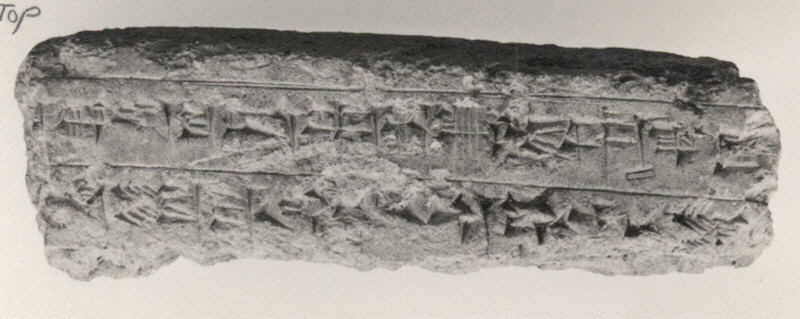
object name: cuneiform tablet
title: Brick with inscription of Nebuchadnezzar II recording his work on Ezida, the temple of the god Nabu at Borsippa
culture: babylonian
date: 604-562 BCE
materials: clay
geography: mesopotamia